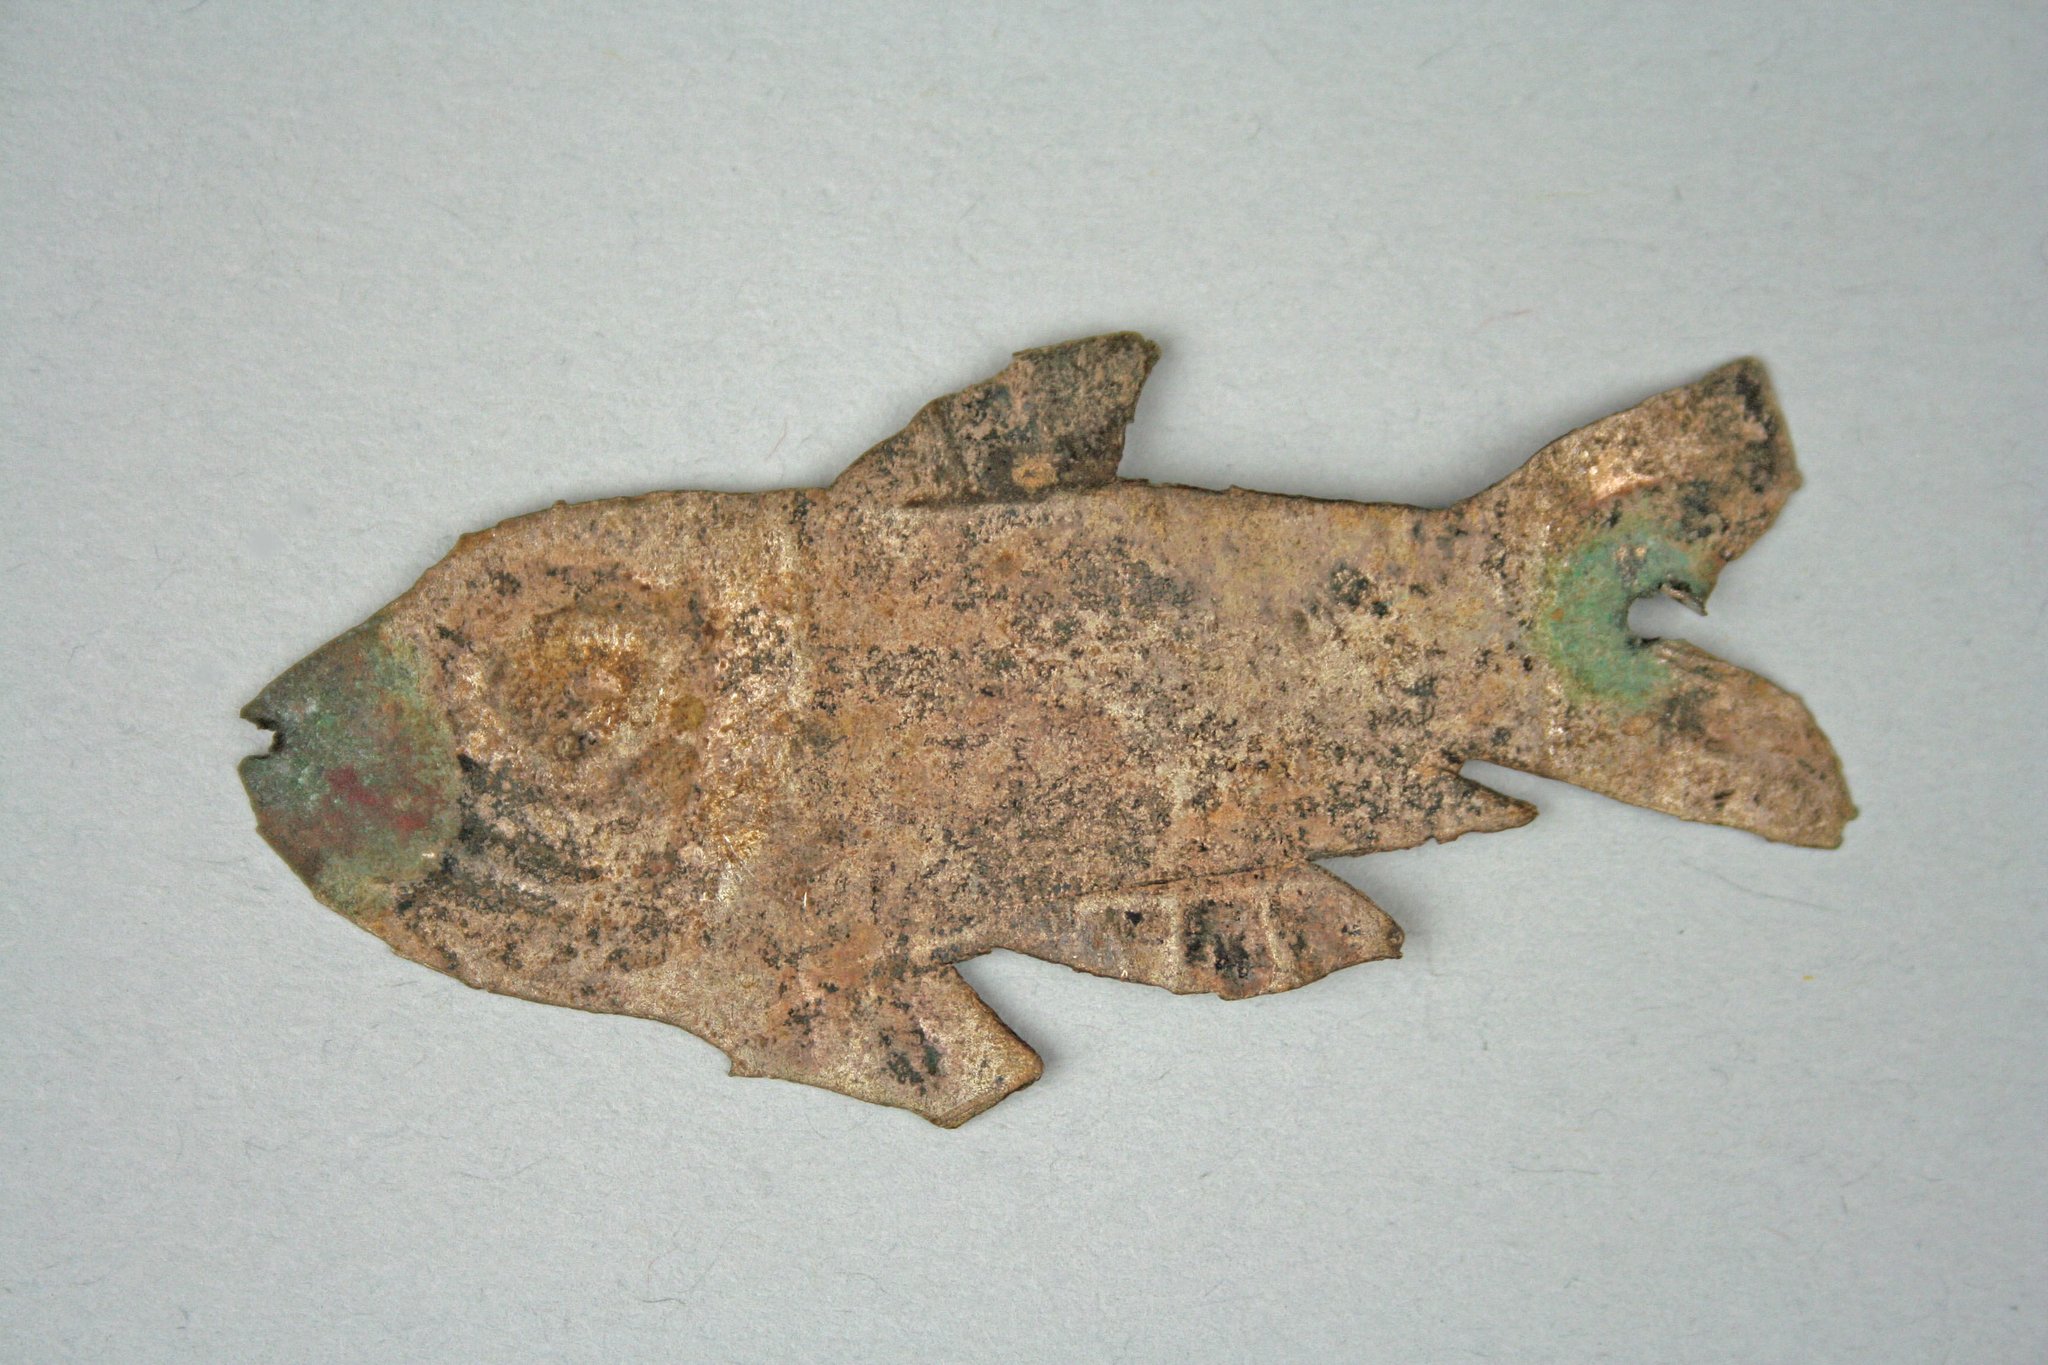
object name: ornament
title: Fish Ornament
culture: peruvian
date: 1001-1200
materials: silver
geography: peru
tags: fish